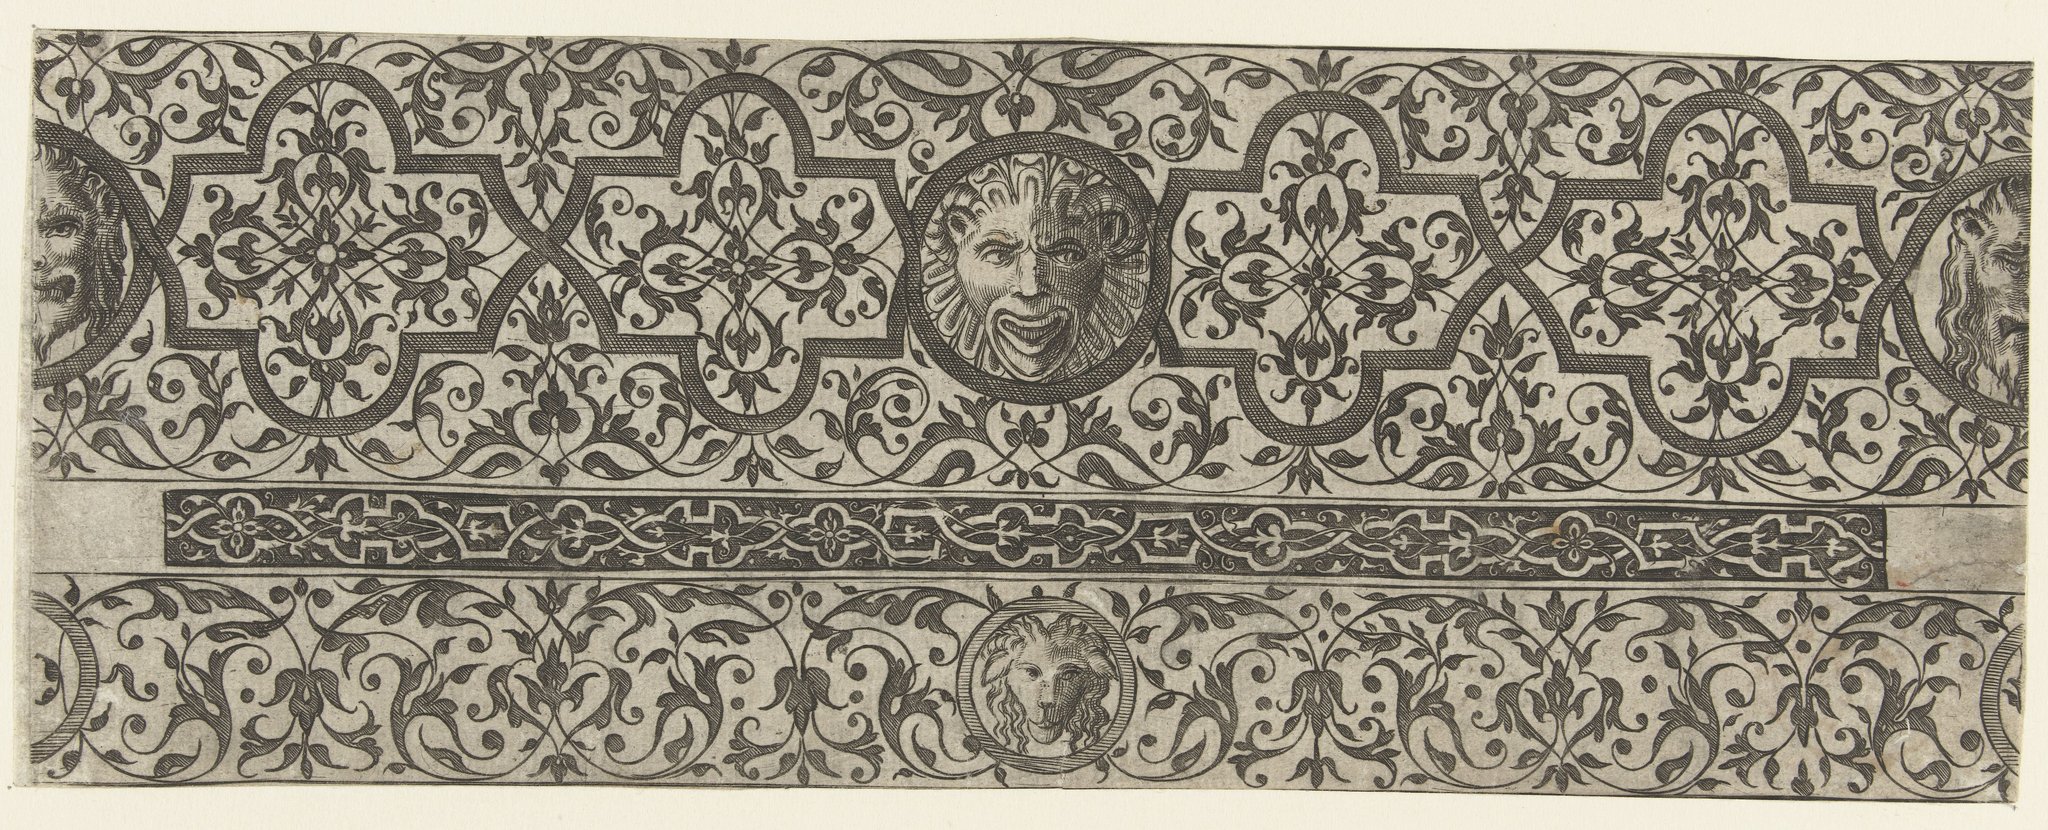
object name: ornament print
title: Friezen en geometrische motieven met moresken en arabesken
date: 1550-1580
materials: paper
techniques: engraving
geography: netherlands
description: Midden in het bovenste fries bevindt zich een mascaron, aan elk uiteinde is een half mascaron zichtbaar. Rechts van het midden bevindt zich een mascaron. Een van 15 bladen afkomstig uit een serie van 23 met titelblad.